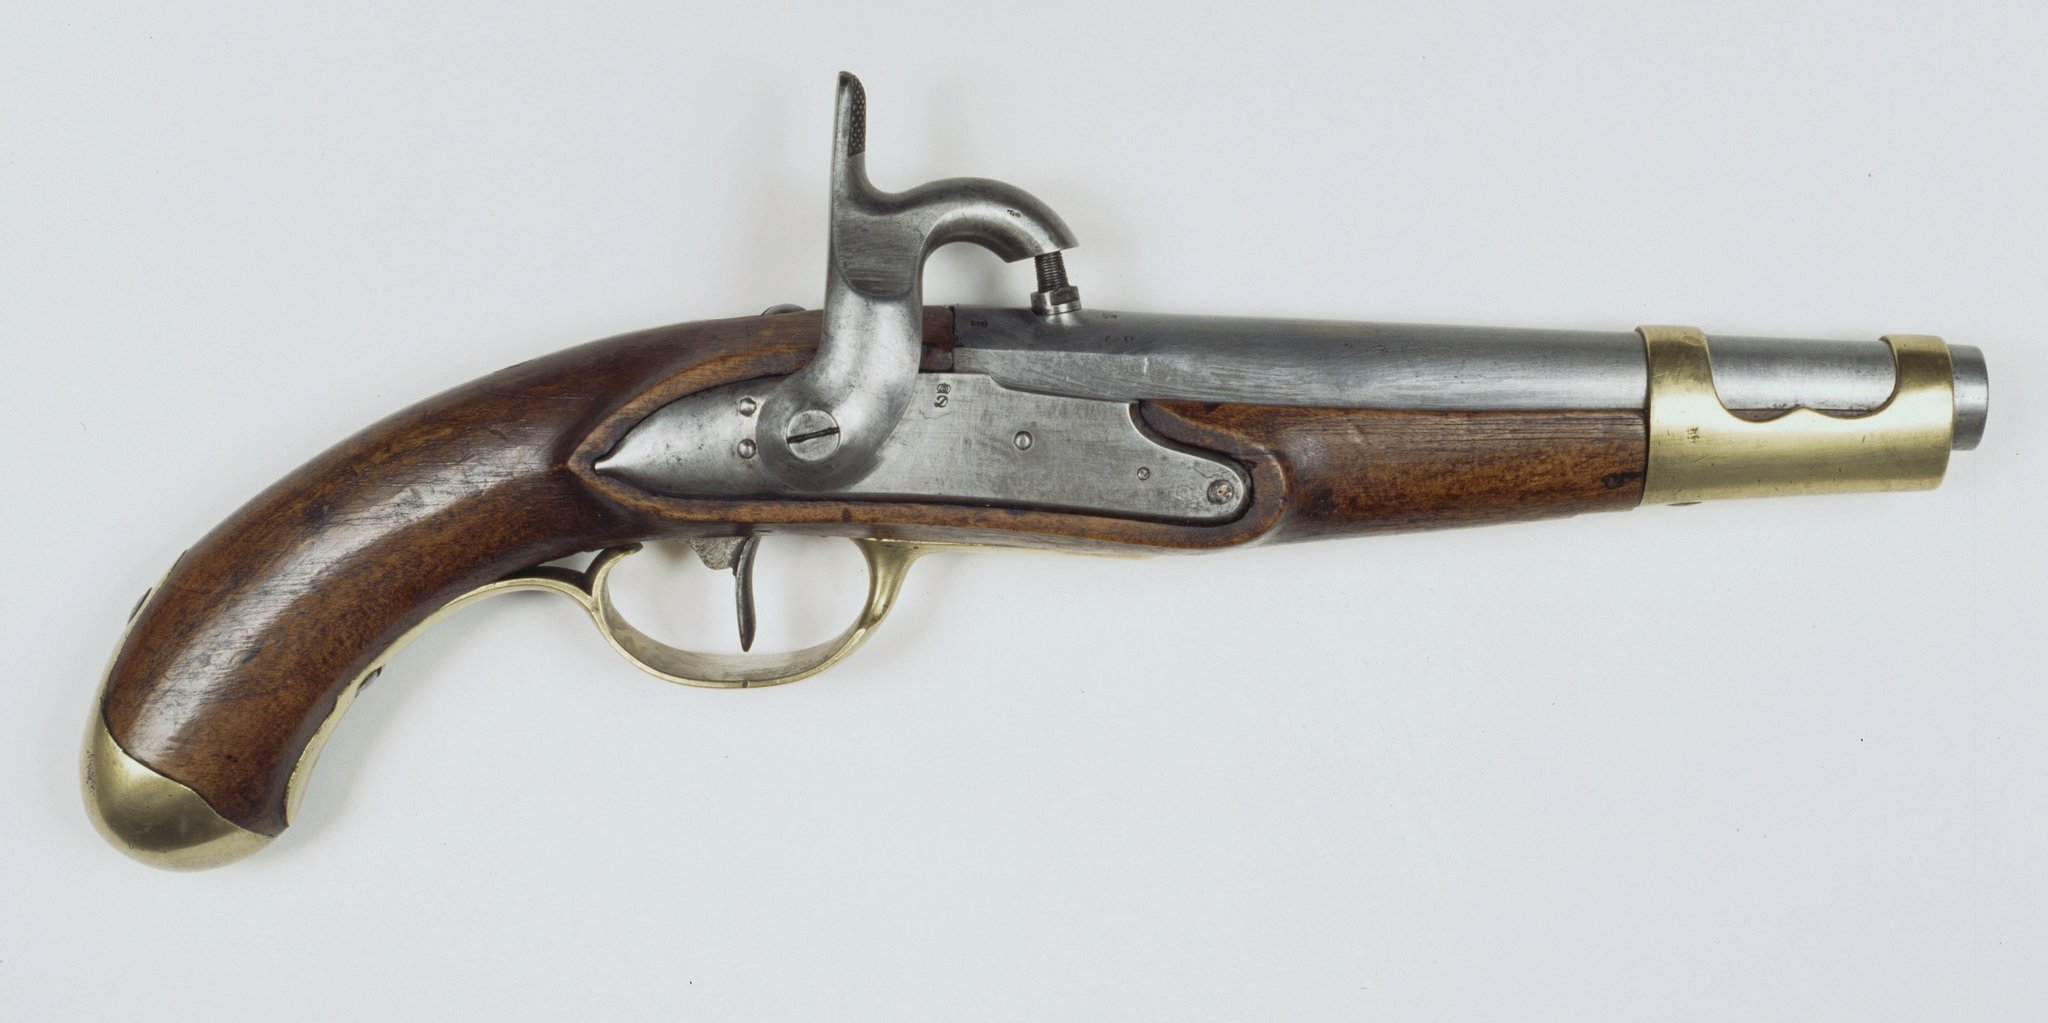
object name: percussion pistol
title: Percussie legerpistool model M 1815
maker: Anonymous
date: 1815-1816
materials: brass, iron, wood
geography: netherlands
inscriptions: signature: ‘B met kroon’, signature: ‘S met kroon’, signature: ‘D met kroon’